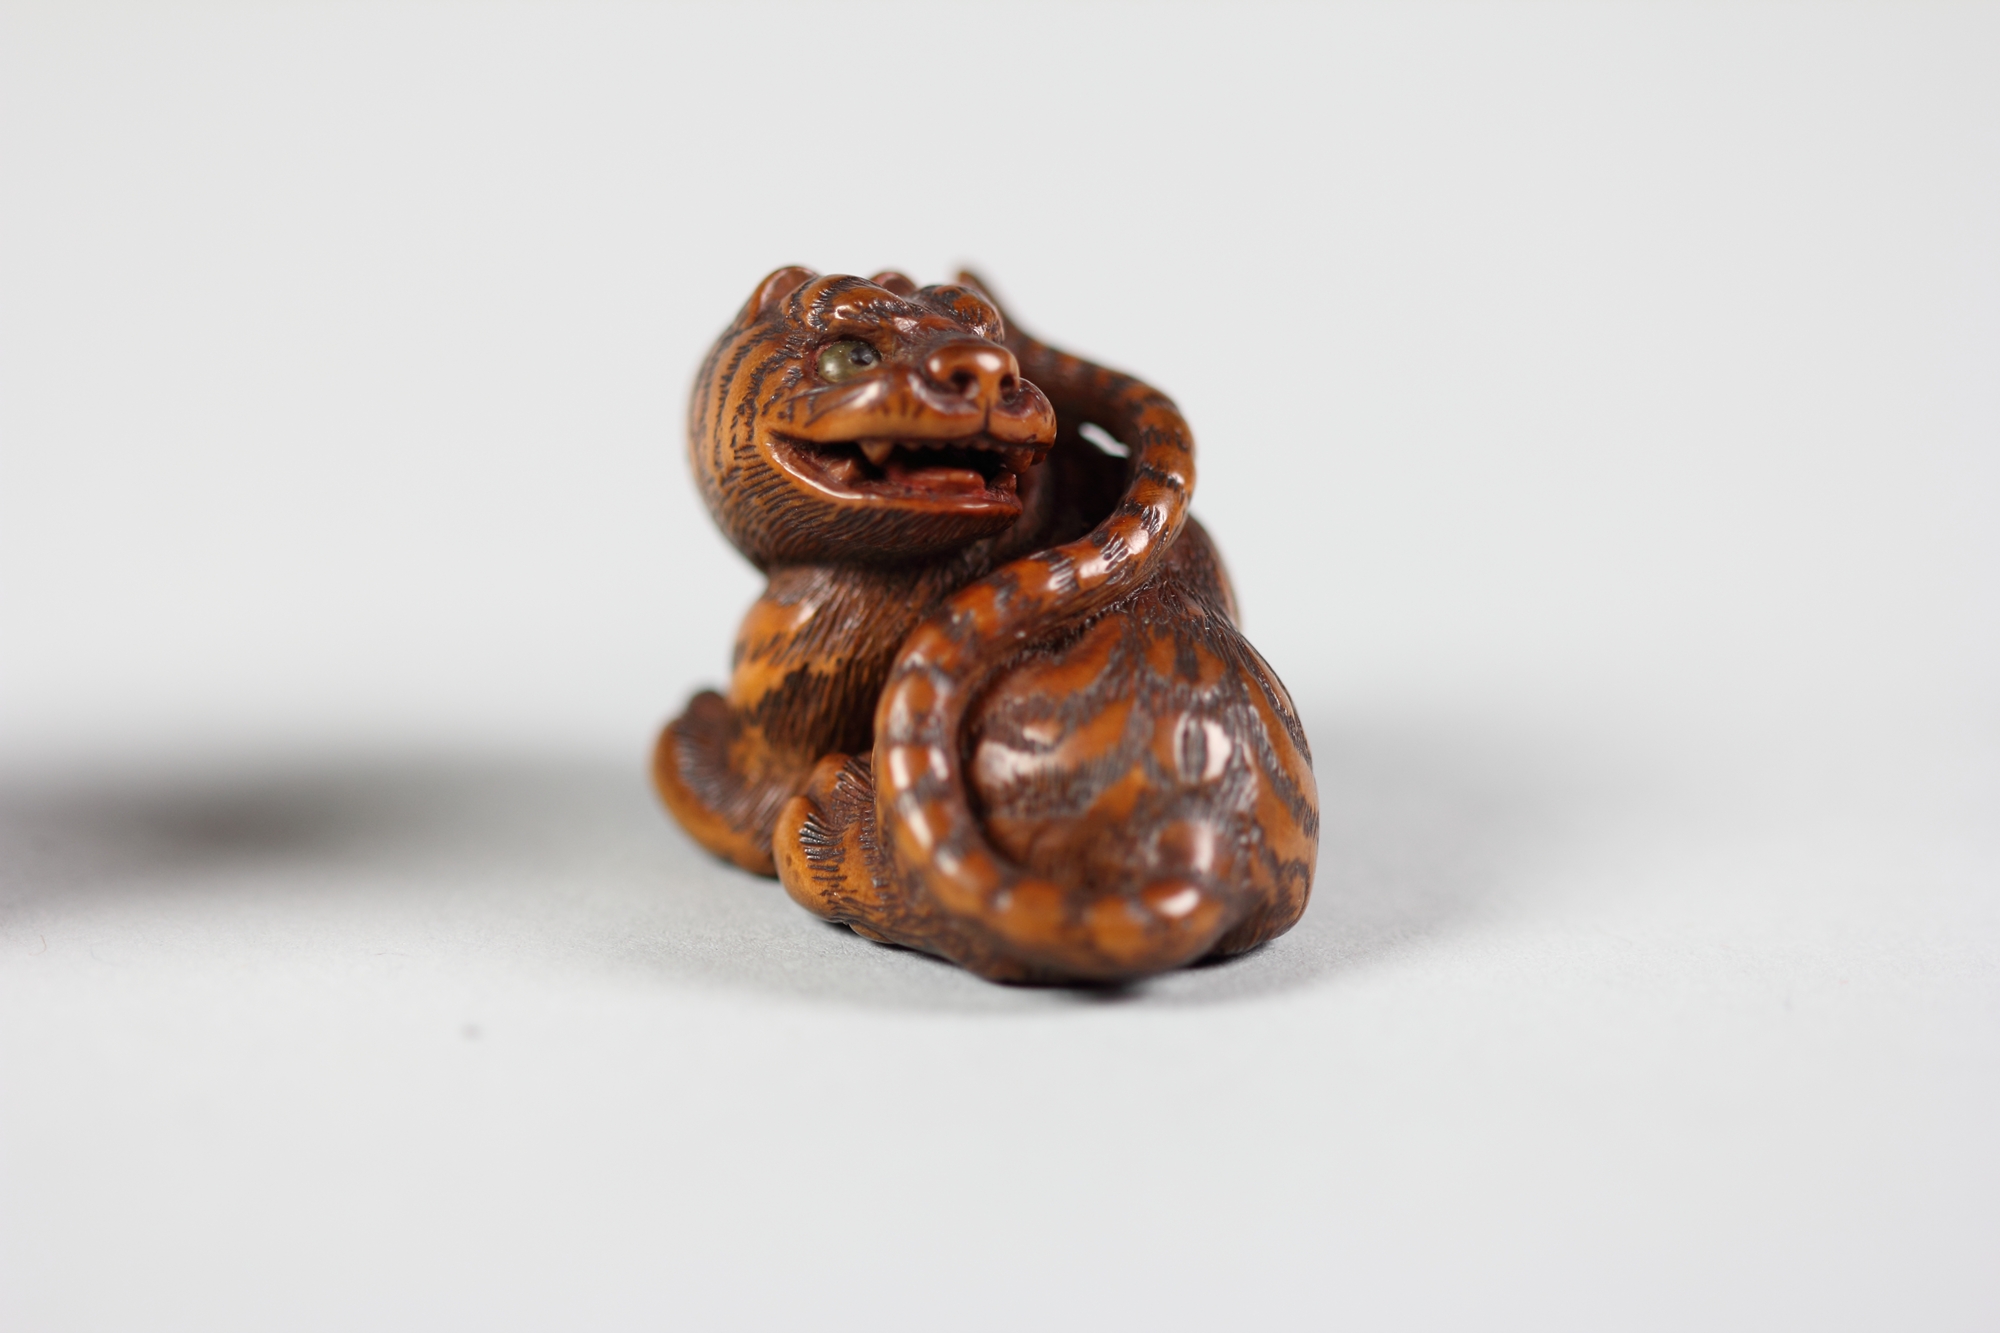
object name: netsuke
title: Tiger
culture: japanese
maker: minkō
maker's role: artist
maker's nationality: japanese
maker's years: 1735-1816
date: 1701-1800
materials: wood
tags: tigers